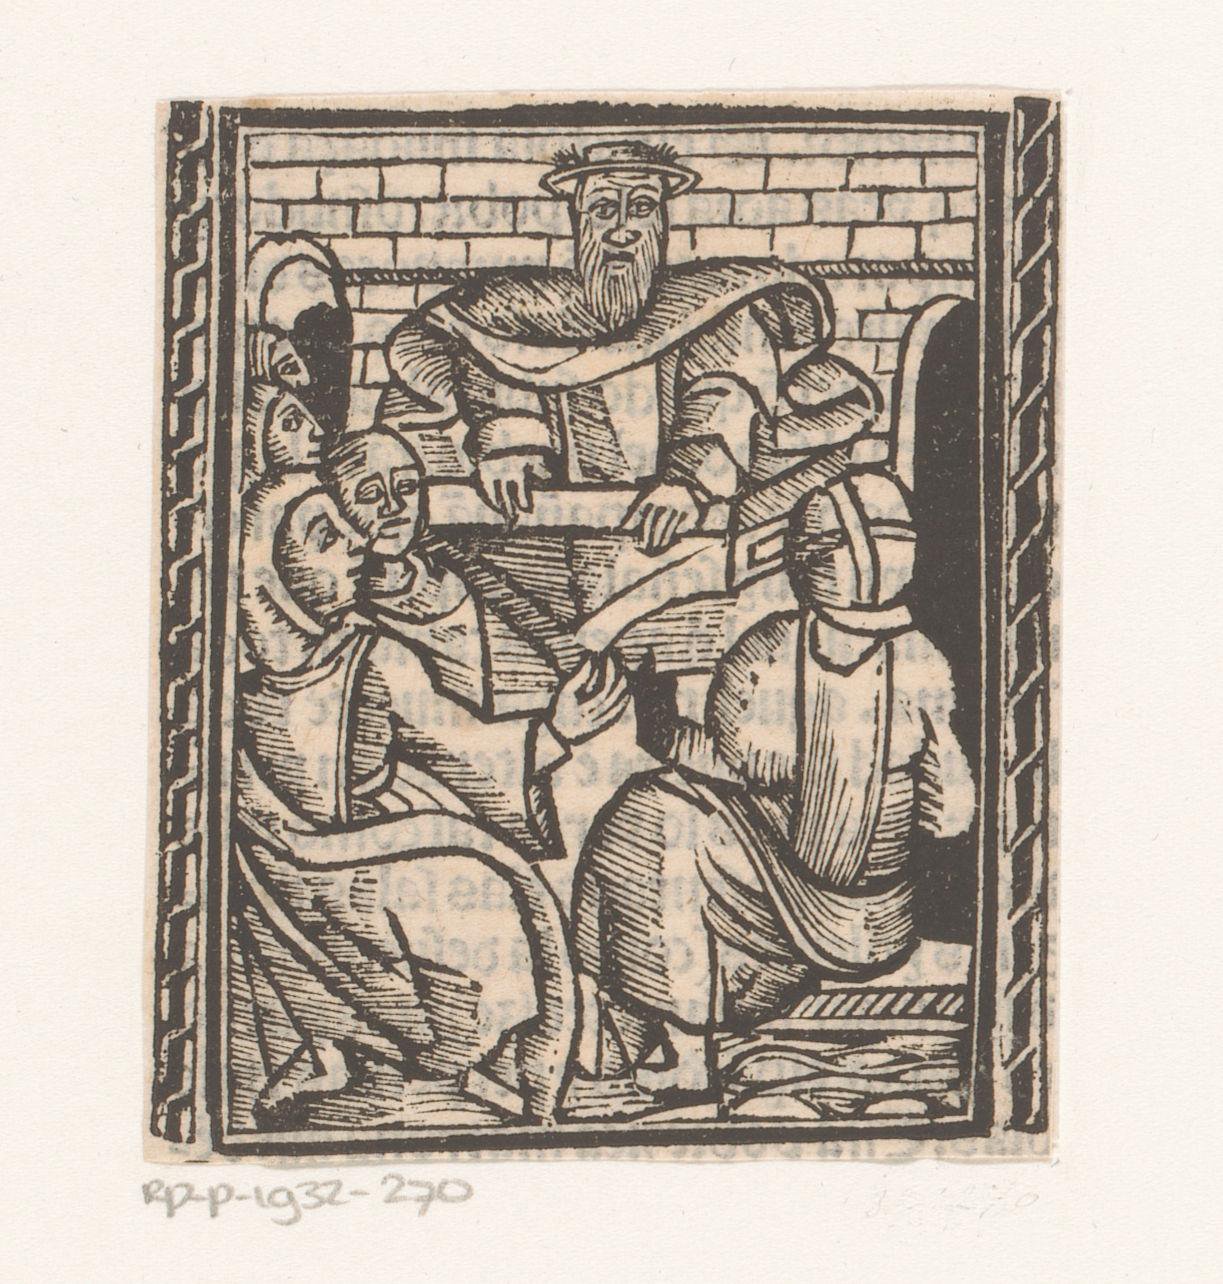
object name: book illustration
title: Prediking van een apostel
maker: Anonymous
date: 1550-1649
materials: paper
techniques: letterpress printing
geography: netherlands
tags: (single) apostle, unspecified, preaching (in general)